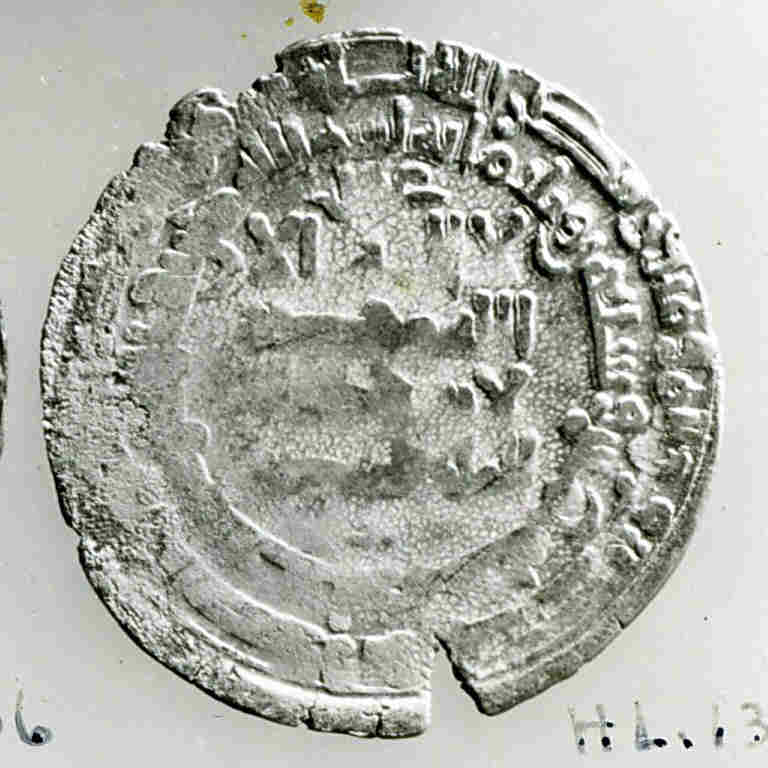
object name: coin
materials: silver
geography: iran